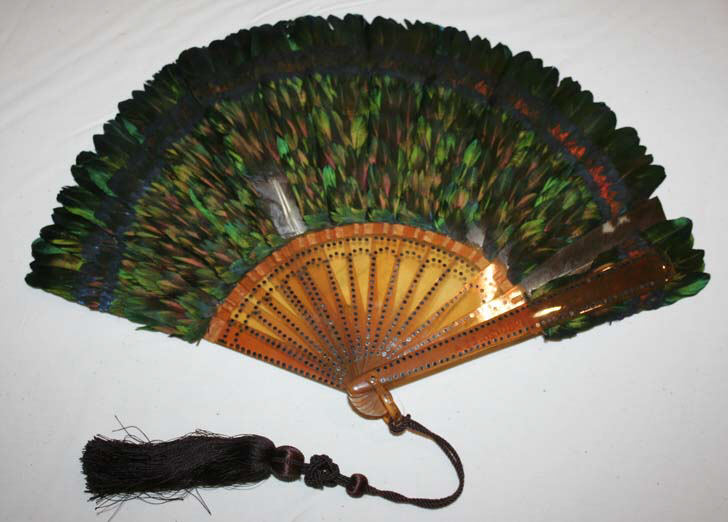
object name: fan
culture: american or european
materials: feather, metal, plastic